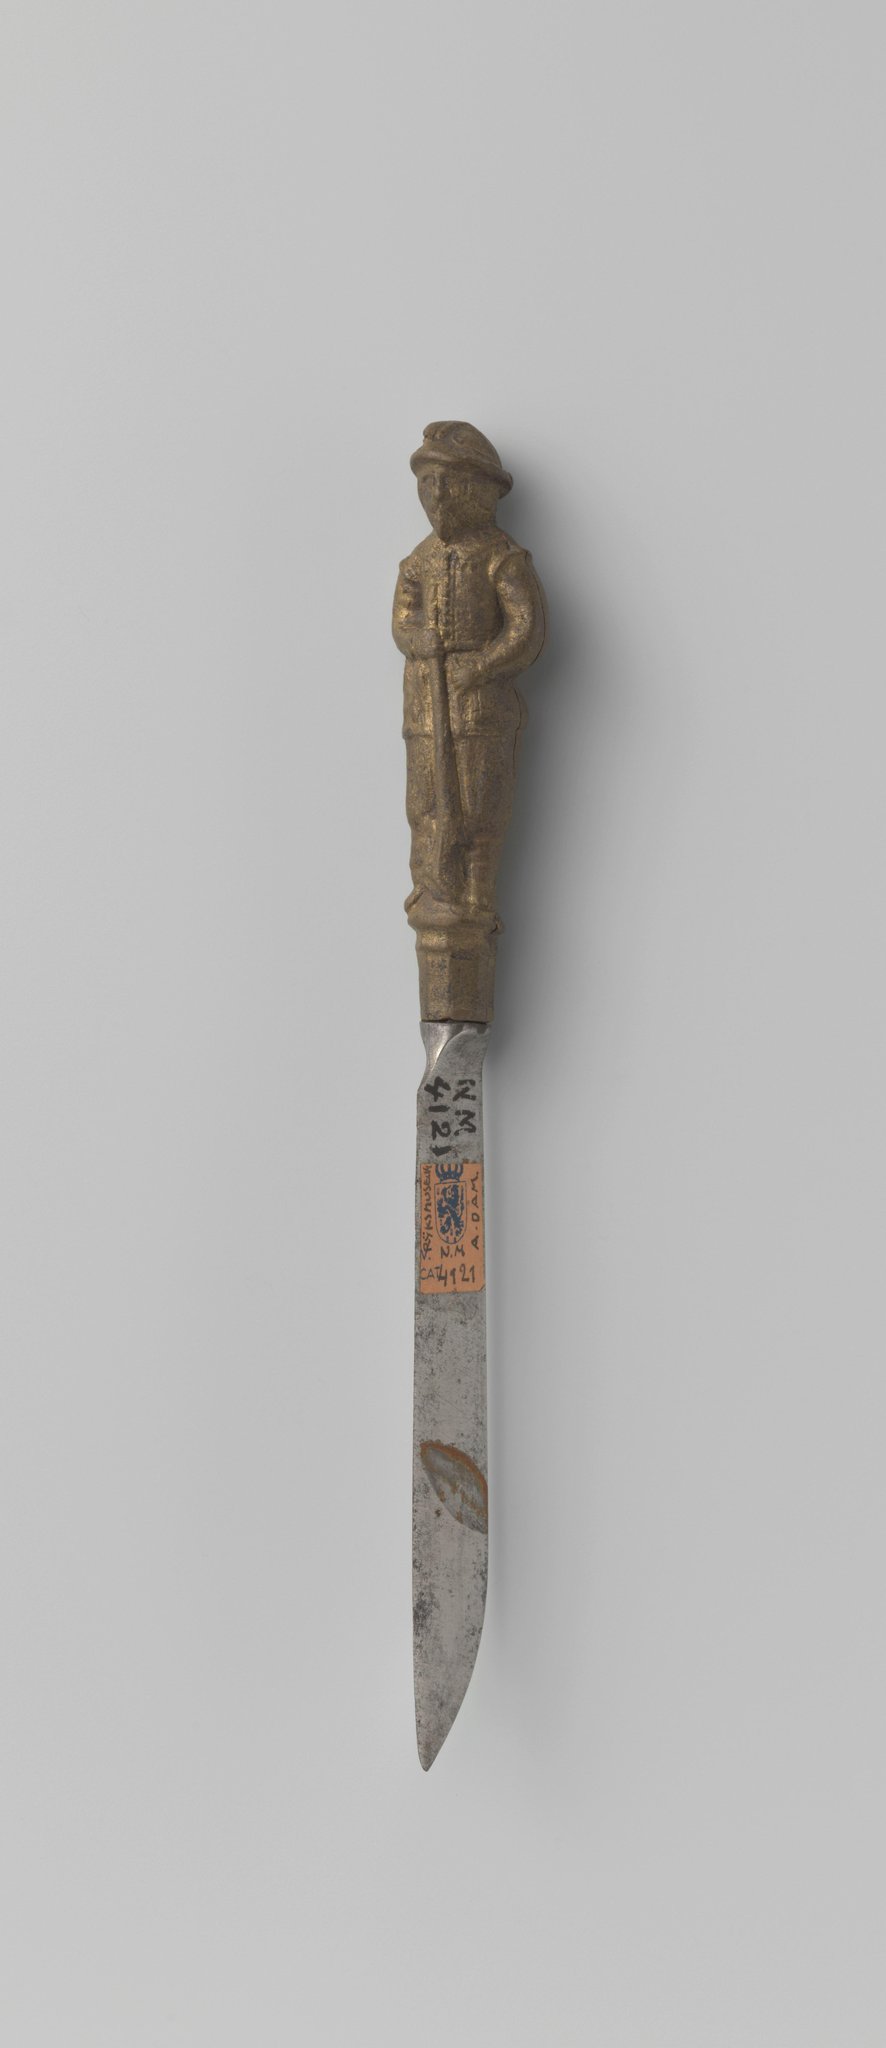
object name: hunting knife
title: Mes met heft in de vorm van een man met musket en jachthond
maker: Anonymous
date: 1600-1650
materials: brass, steel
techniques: casting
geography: netherlands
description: Een dergelijk heft is gevonden in het wrak van het schip 'De Lastdrager', dat in 1653 bij Shetland is vergaan. Onno ter Kuile, 1986.